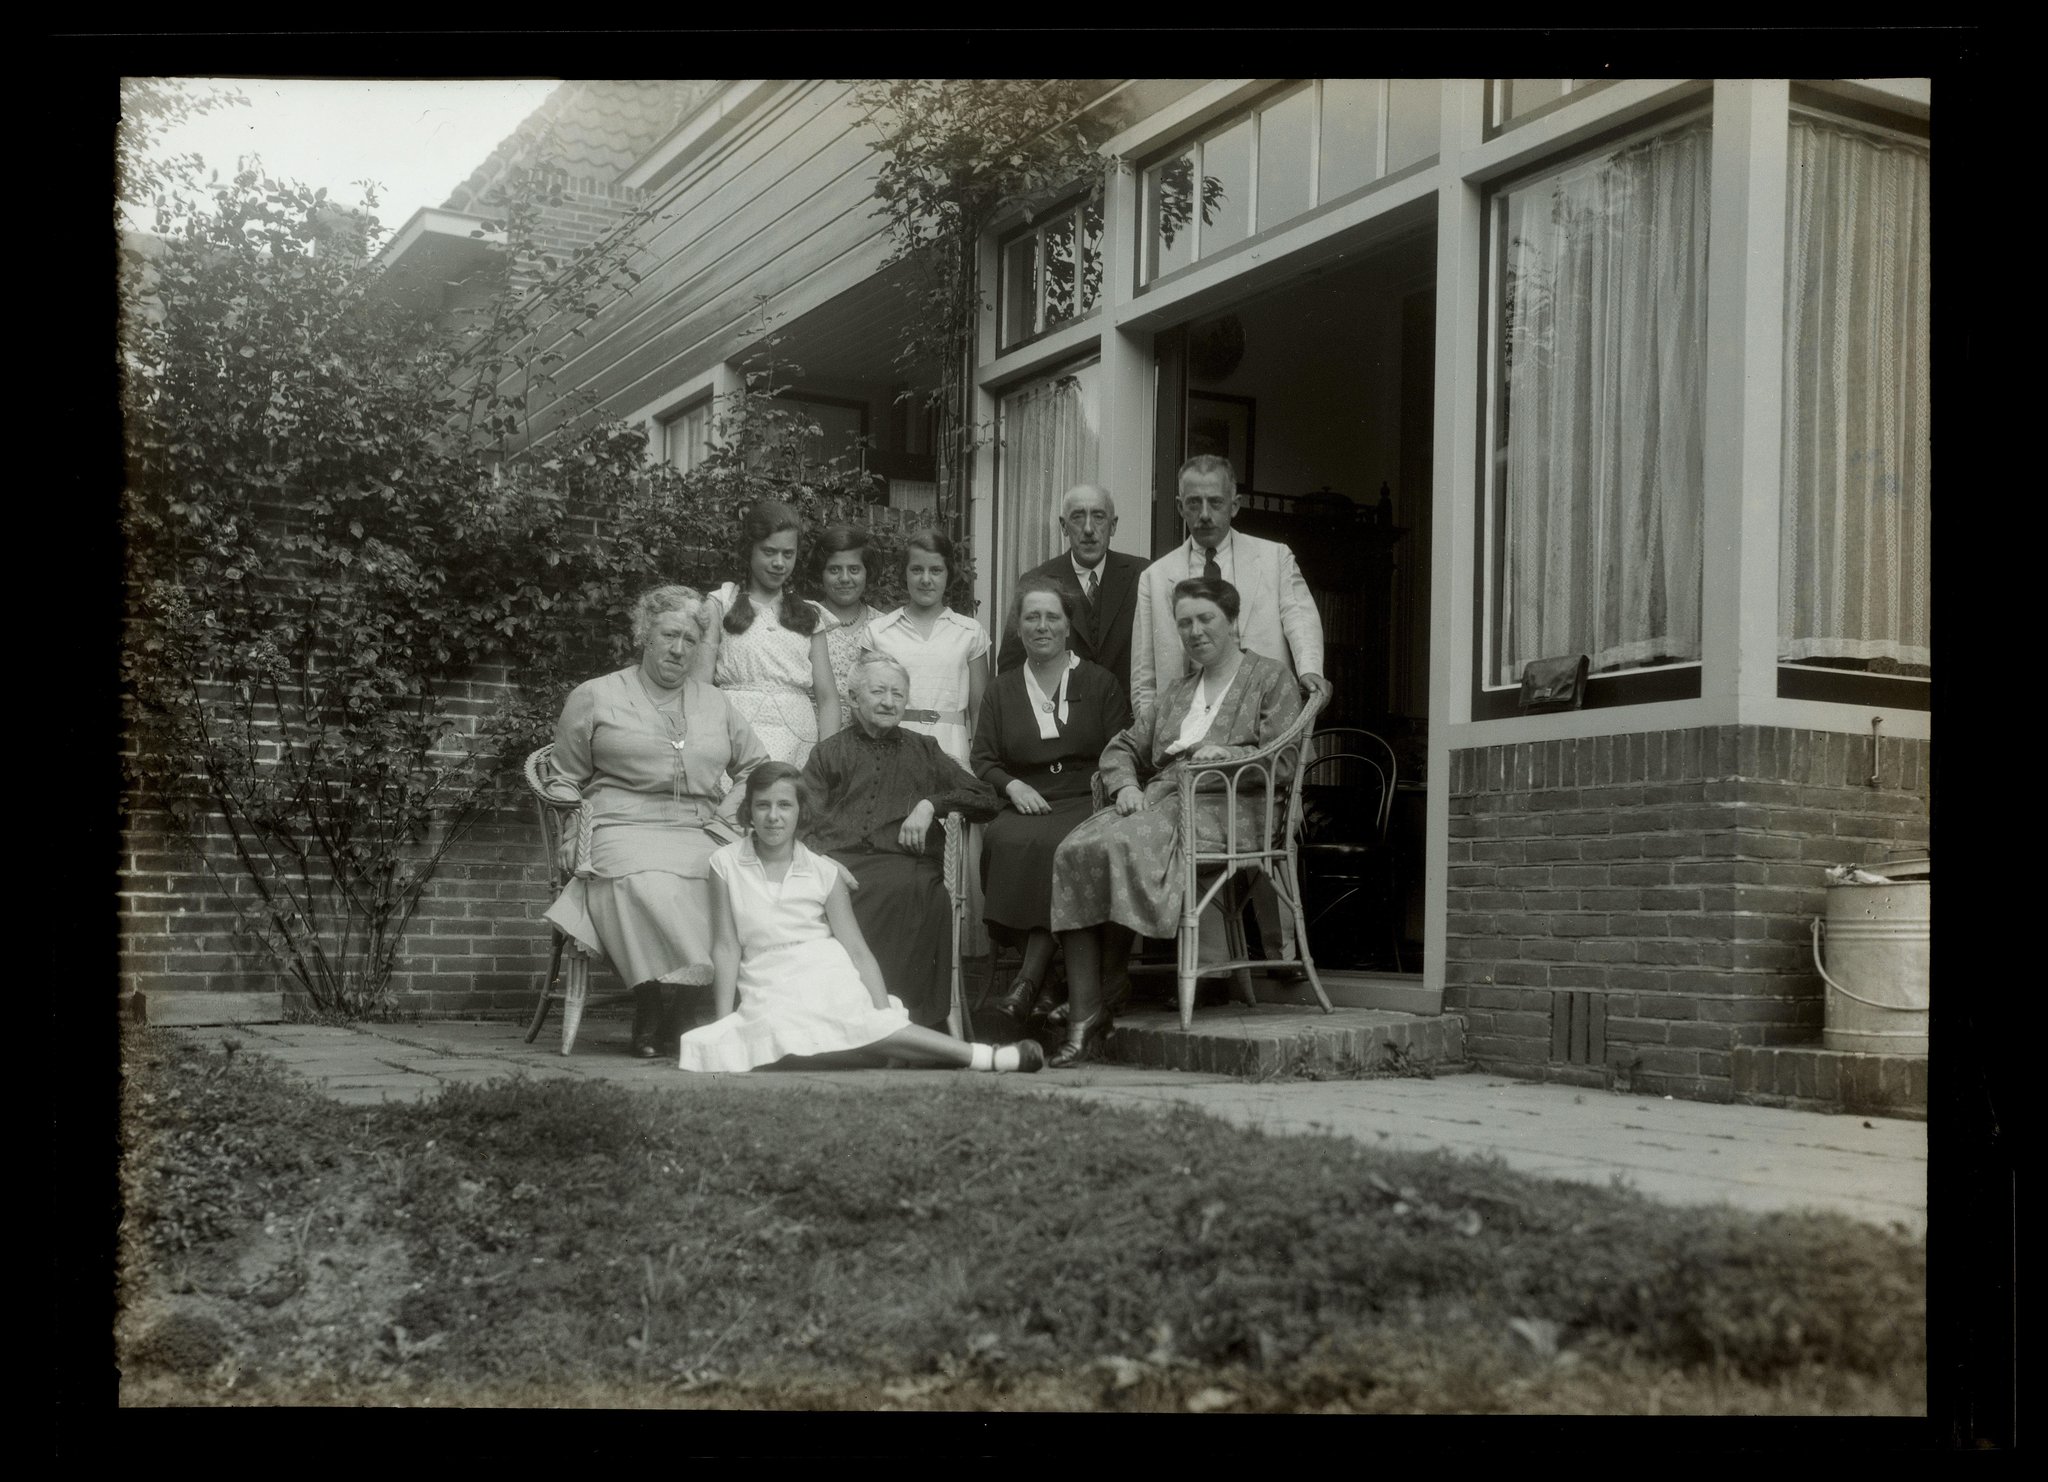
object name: negative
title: Filmnegatief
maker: Anonymous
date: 1907-1935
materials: film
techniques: gelatin silver negative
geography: europe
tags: europe